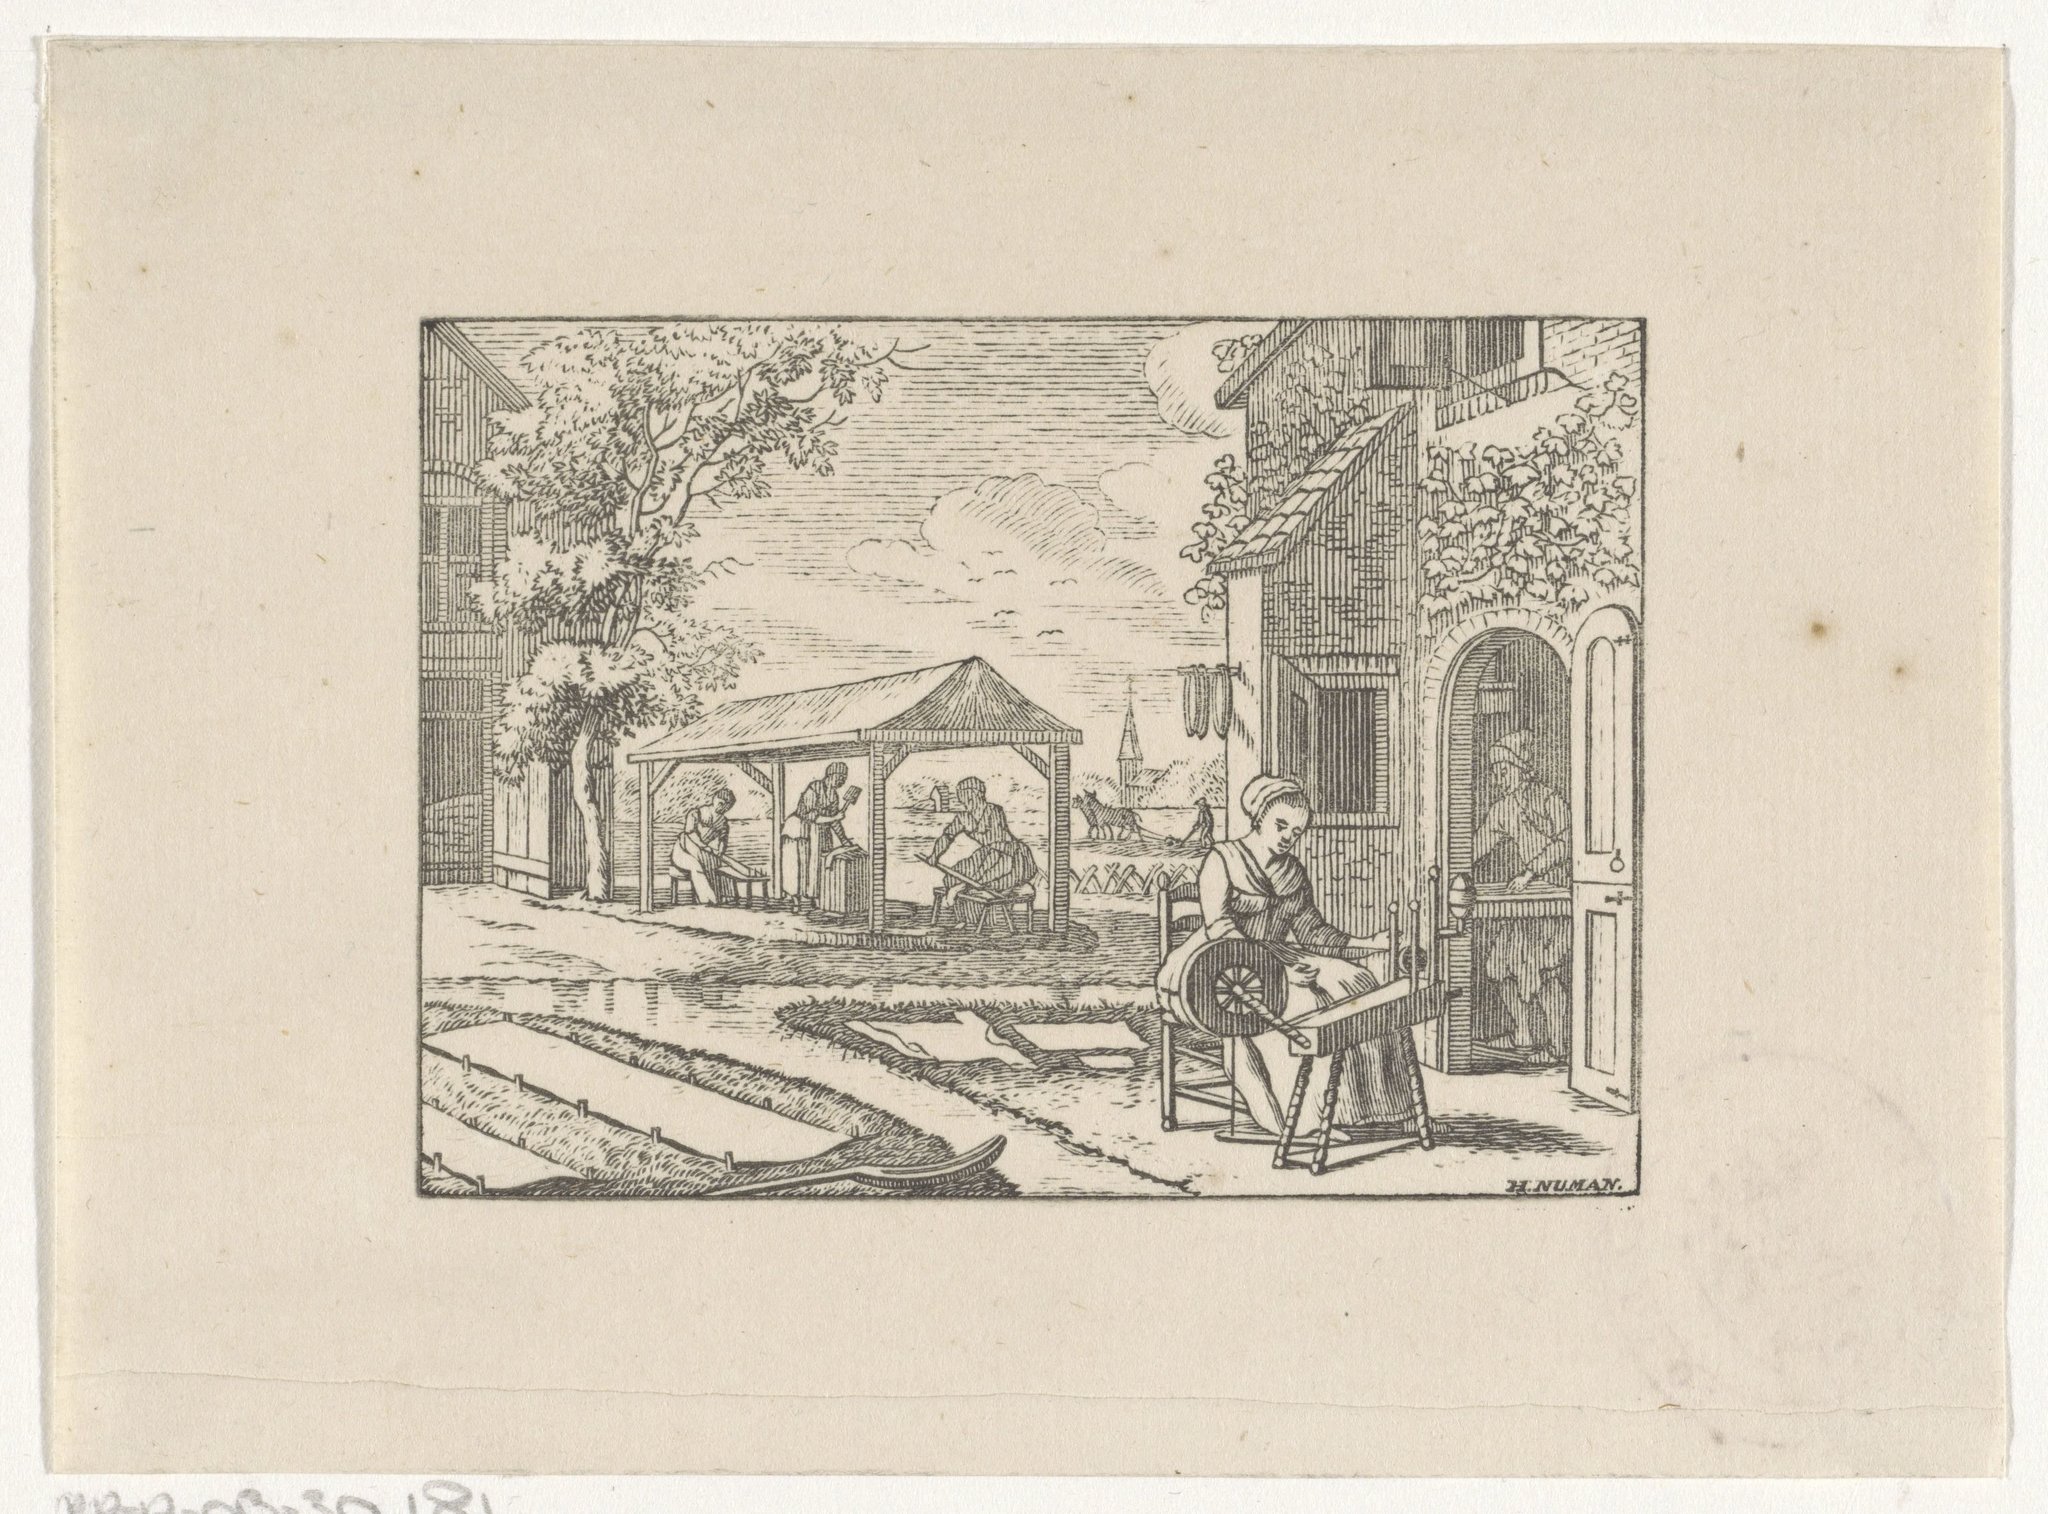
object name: print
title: Figuren in een textielwerkplaats aan het werk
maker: hendrik numan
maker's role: draughtsman, print maker, publisher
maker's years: 1736-1788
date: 1746-1788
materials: paper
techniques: woodcut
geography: haarlem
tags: textile industry and clothing industry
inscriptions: collector's mark: Lugt 240